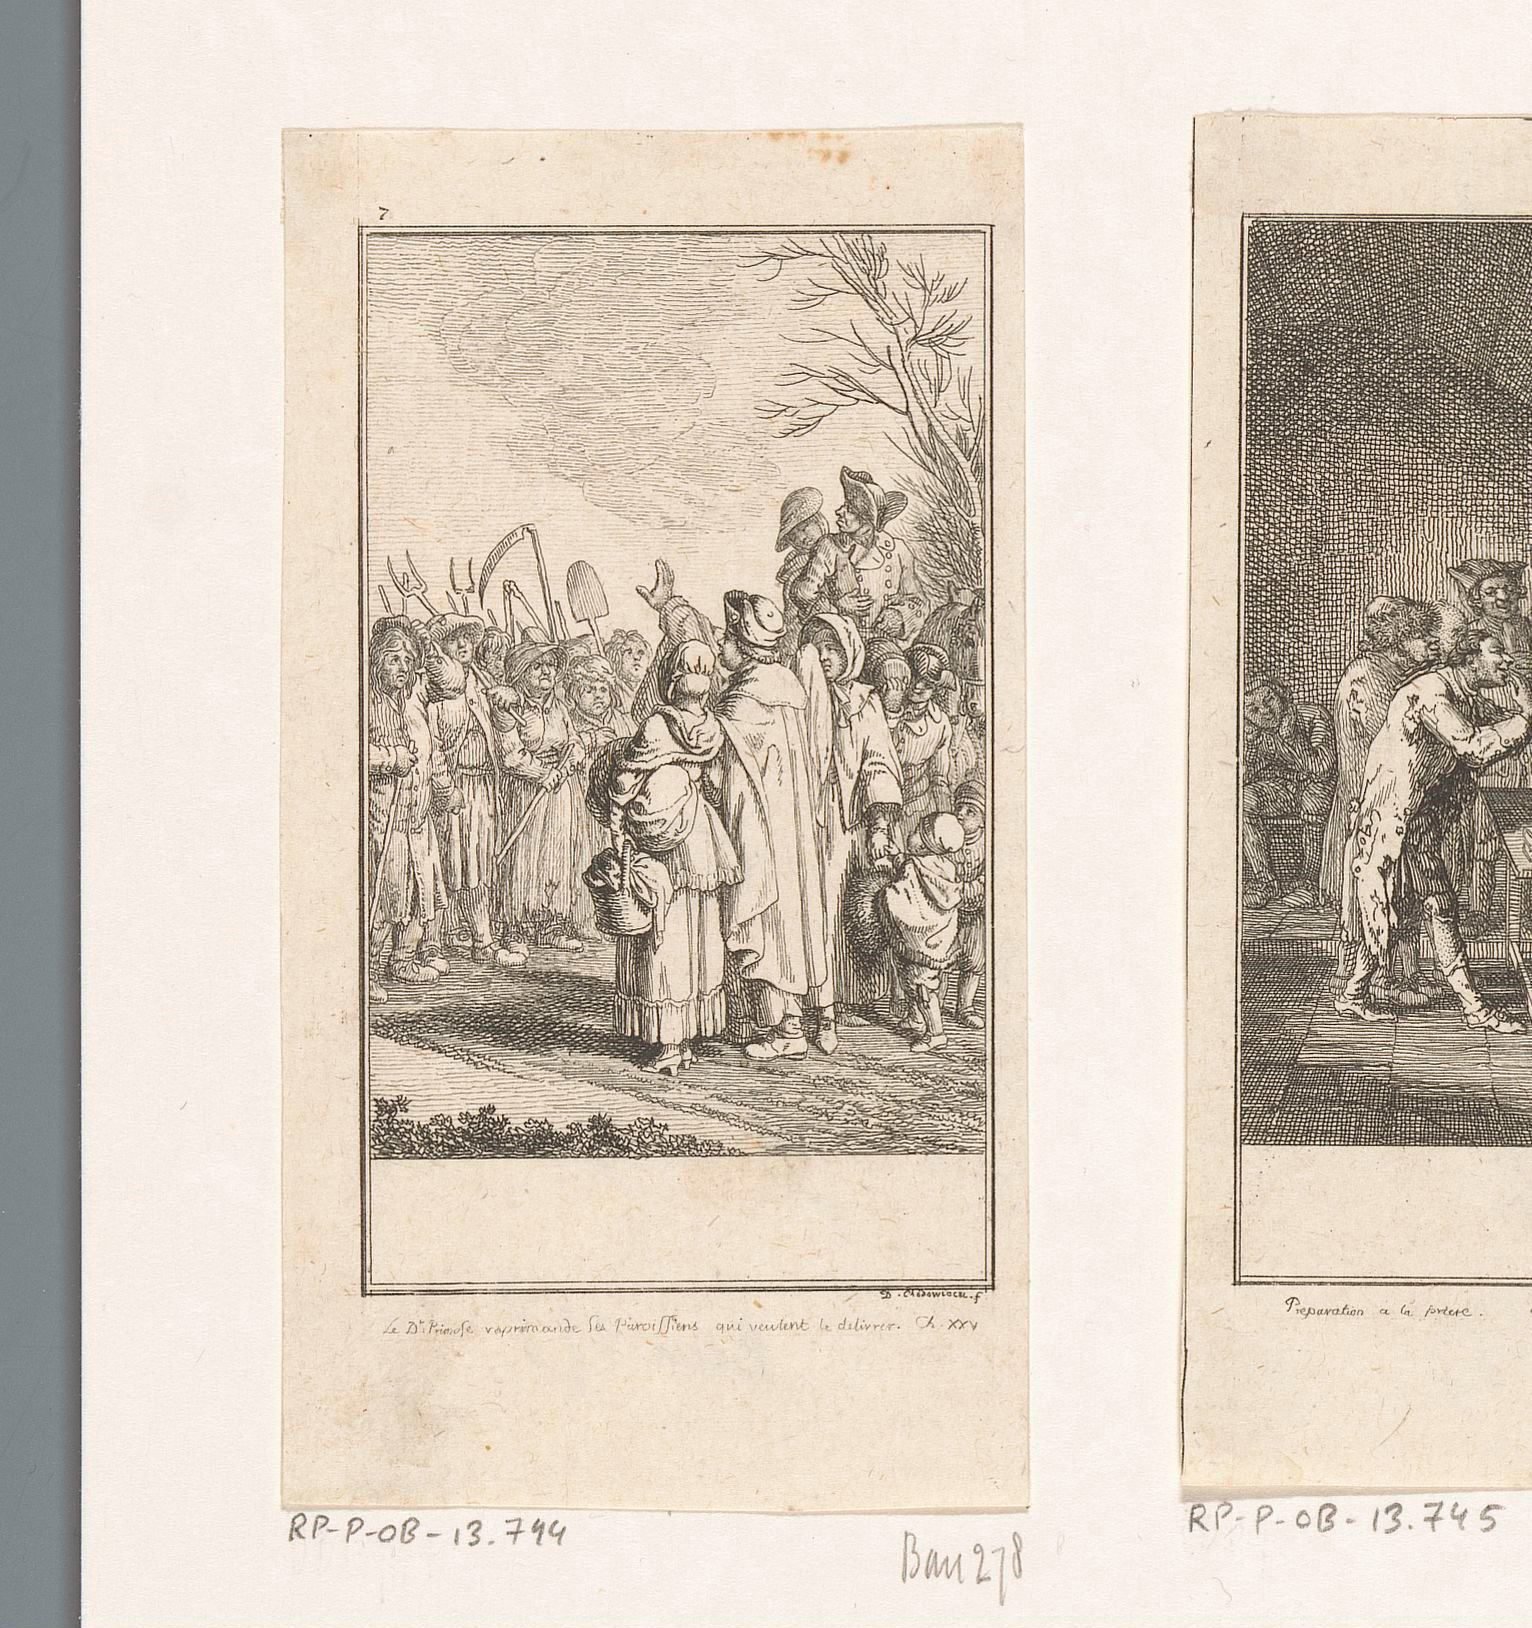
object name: print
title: Le Dr Primrose reprimande Ses Paroissiens qui veulent le delivrer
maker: daniel nikolaus chodowiecki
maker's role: draughtsman, print maker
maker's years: 1726-1801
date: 1776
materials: paper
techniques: etching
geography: berlin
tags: london, oliver goldsmith, crowd, mob, (goldsmith, the vicar of wakefield) specific works of literature (with author, title)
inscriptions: collector's mark: Lugt 2228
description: Door toedoen van Squire Thornhill wordt Charles Primrose vanwege een openstaande schuld afgevoerd naar de gevangenis. Vijftig arme lidmaten van zijn gemeente proberen dit met geweld te voorkomen. Charles Primrose maant hen tot kalmte en vertrekt rustig naar de gevangenis. Linksboven genummerd: 7.